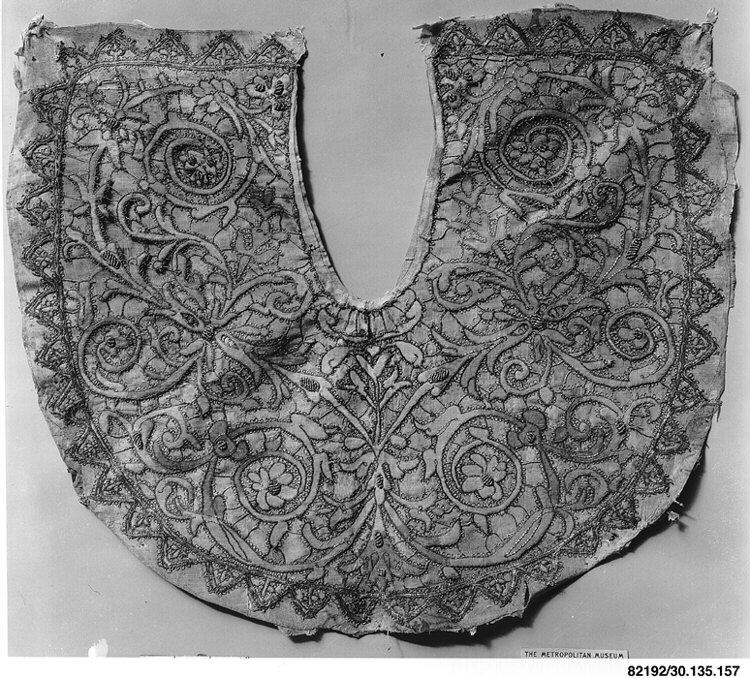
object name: collar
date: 1634-1666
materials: linen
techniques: embroidery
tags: flowers